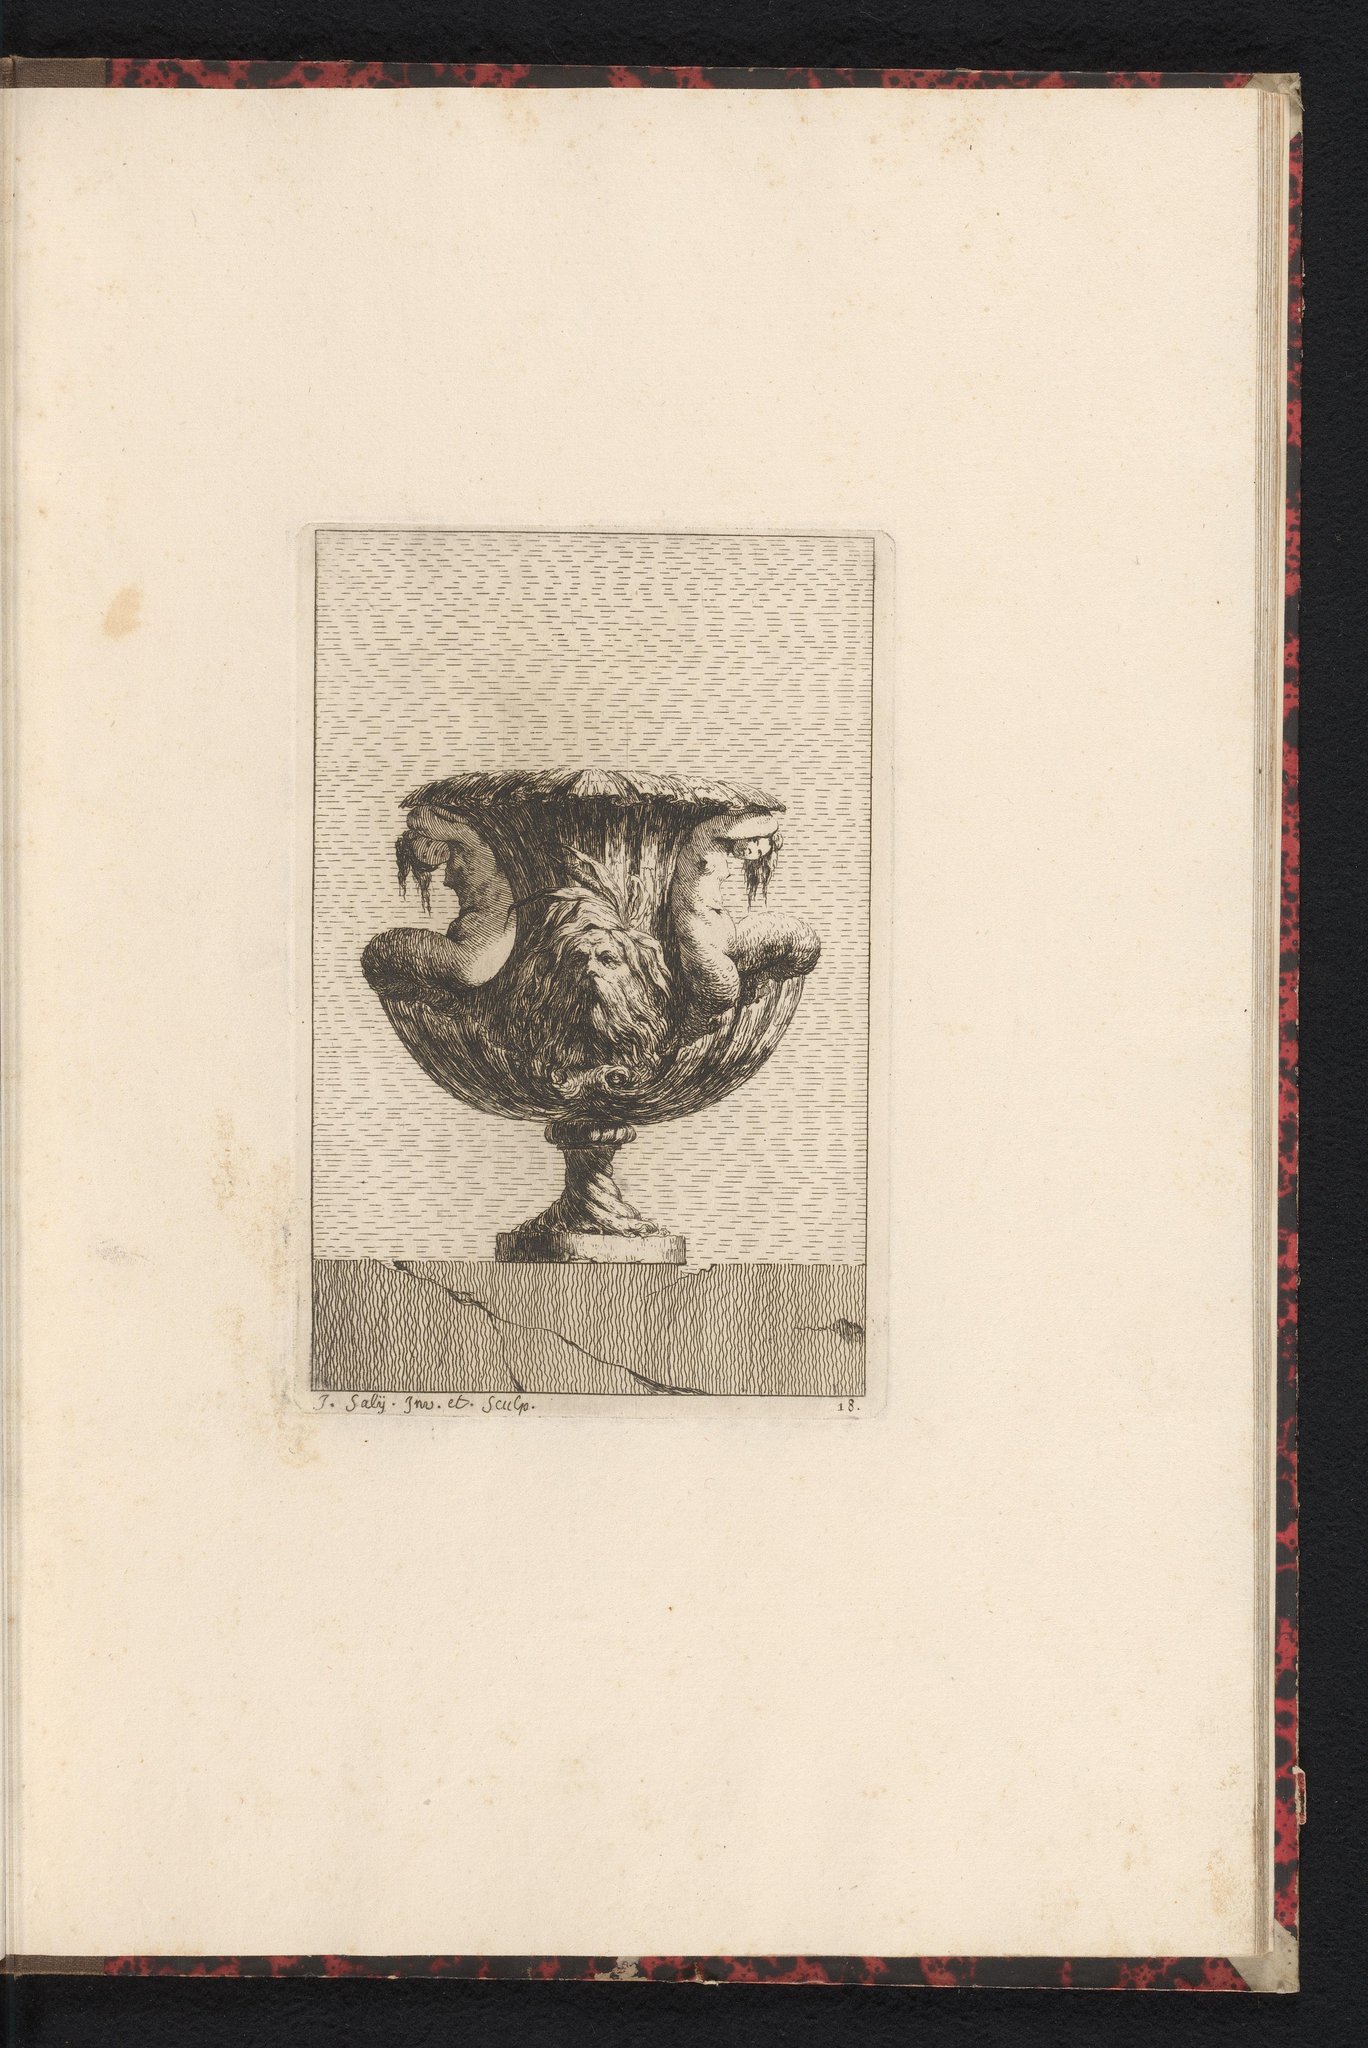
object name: album leaf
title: Vasa a se inventa atq. studii causa delin. et incisa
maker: jacques francois joseph saly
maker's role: print maker, sculptor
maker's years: 1717-1776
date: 1746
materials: paper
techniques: etching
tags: merman - aa - mermaid, siren, river-gods, garden vase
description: Deze prent maakt deel uit van een album.